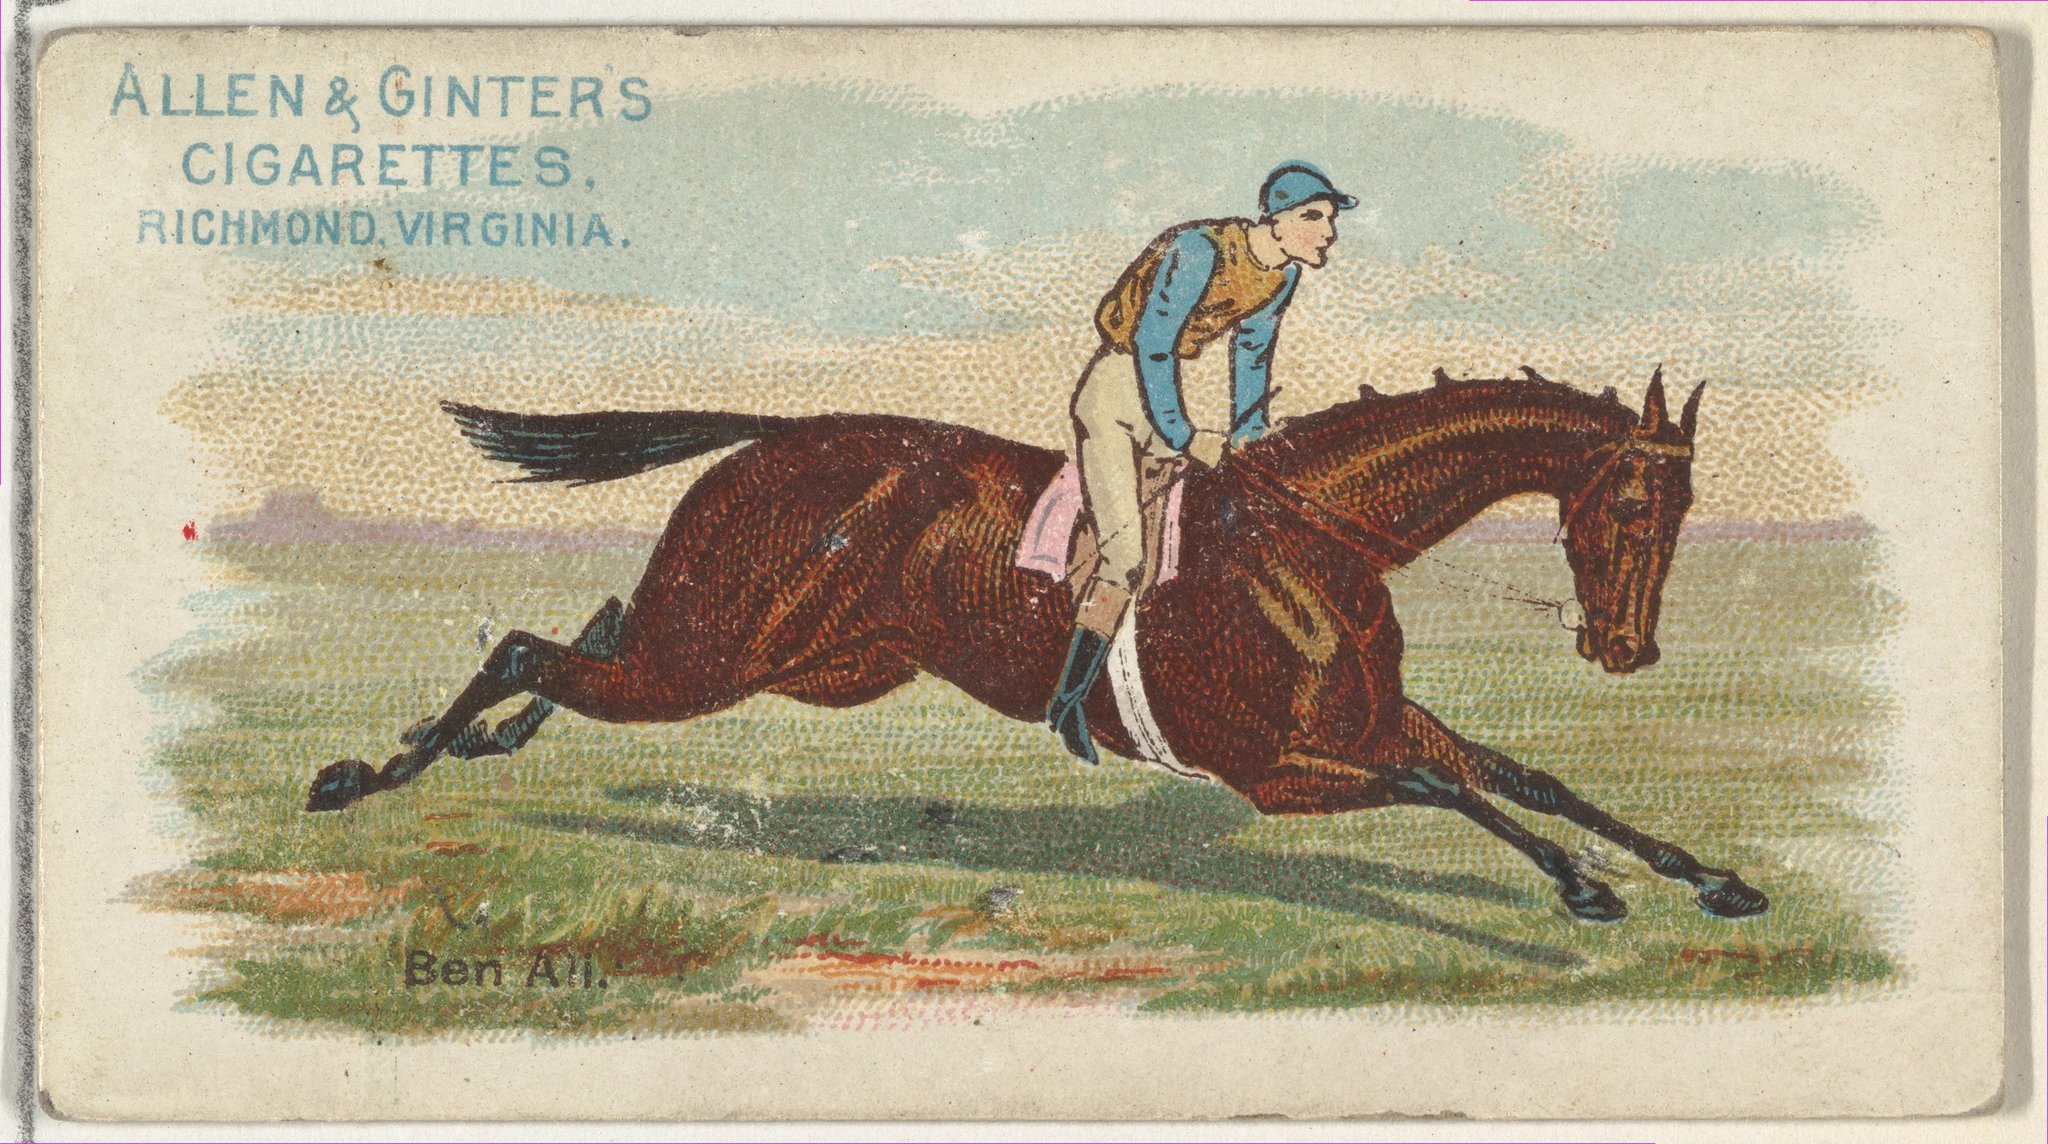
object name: print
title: From The World's Racers series (N32) for Allen & Ginter Cigarettes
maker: allen & ginter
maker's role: publisher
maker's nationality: american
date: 1888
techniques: color lithograph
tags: men,horses,jockeys